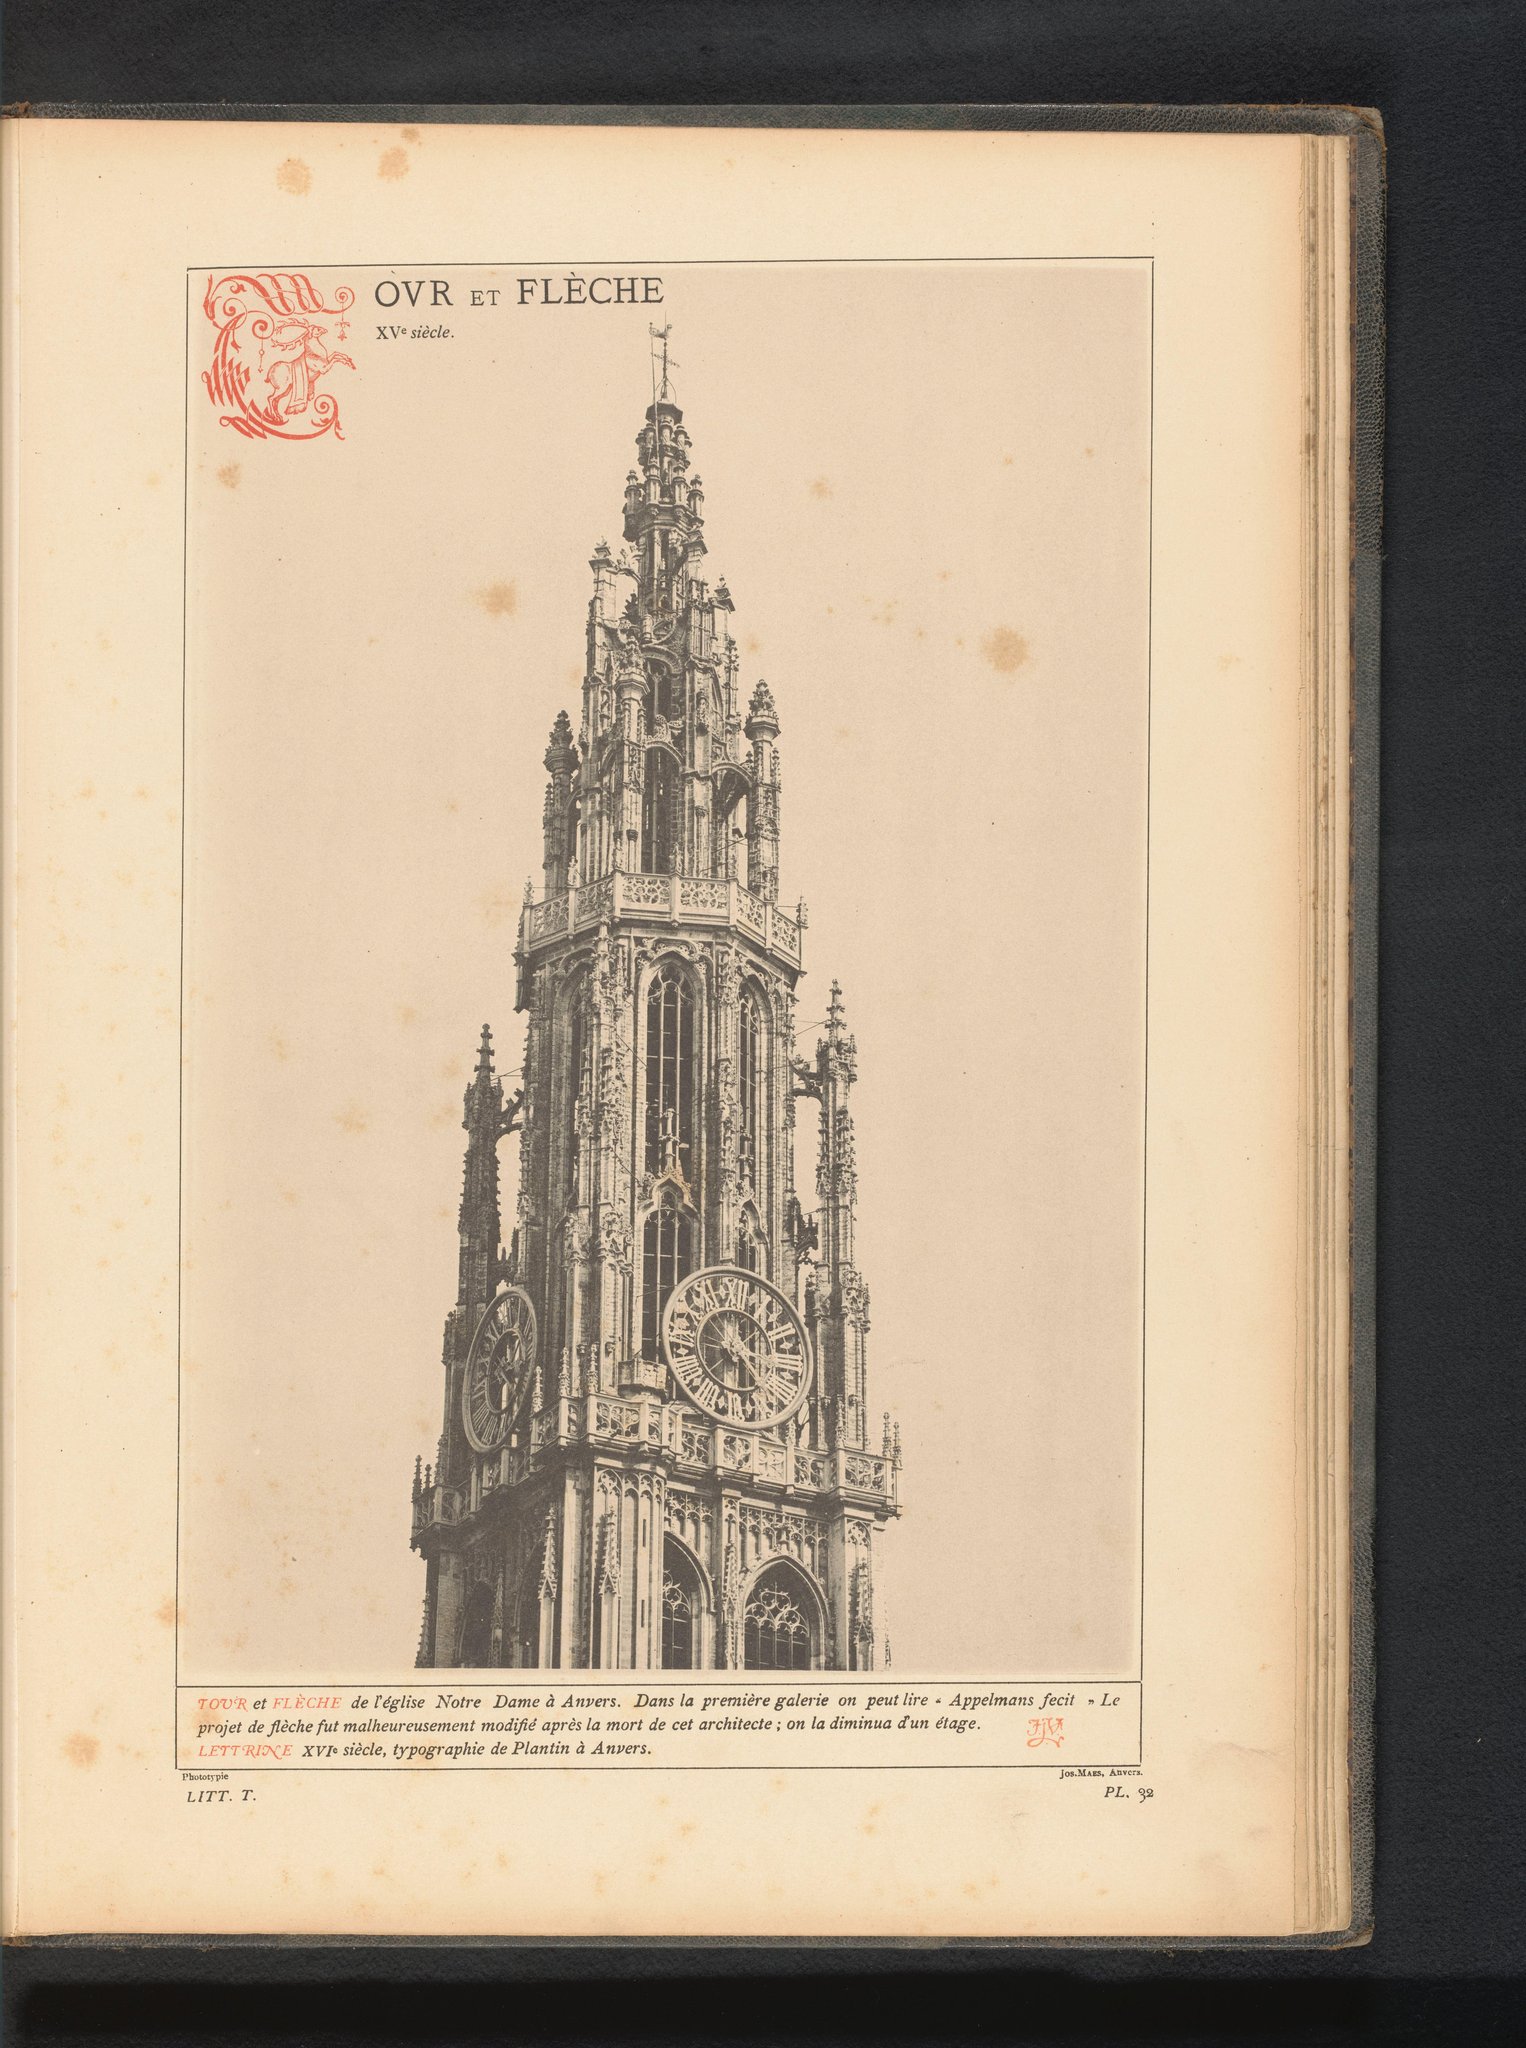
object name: page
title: Toren en torenspits van de Onze-Lieve-Vrouwekathedraal te Antwerpen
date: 1876-1881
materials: paper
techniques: photograph, photolithography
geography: antwerp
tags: parts of church exterior and annexes: spire, parts of church exterior and annexes: tower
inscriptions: inscription: ‘LITT. T. - PL. 32.’, monogram: ‘JJvY’, inscription: ‘TOUR ET FLÈCHE (...)’